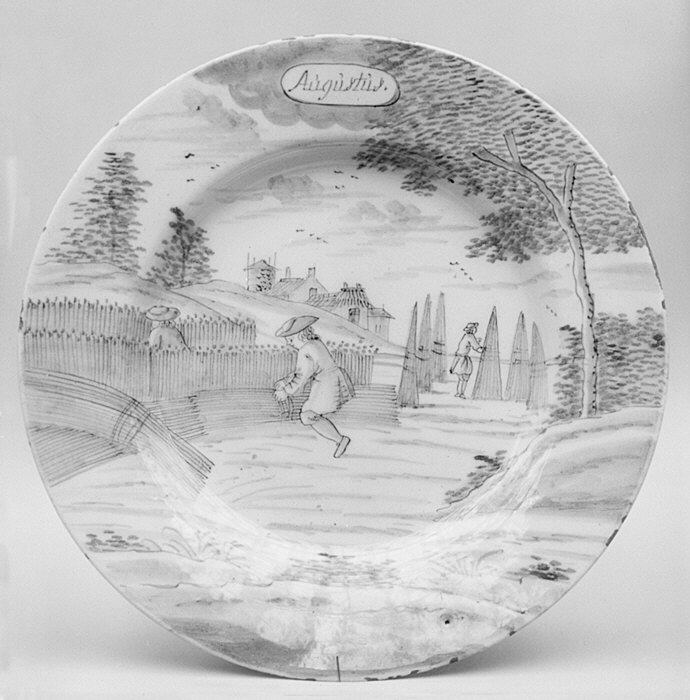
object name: plate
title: Plate (part of a set)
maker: de porceleyne bijl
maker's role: maker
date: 1764-1788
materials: earthenware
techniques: glazing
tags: houses,trees,working